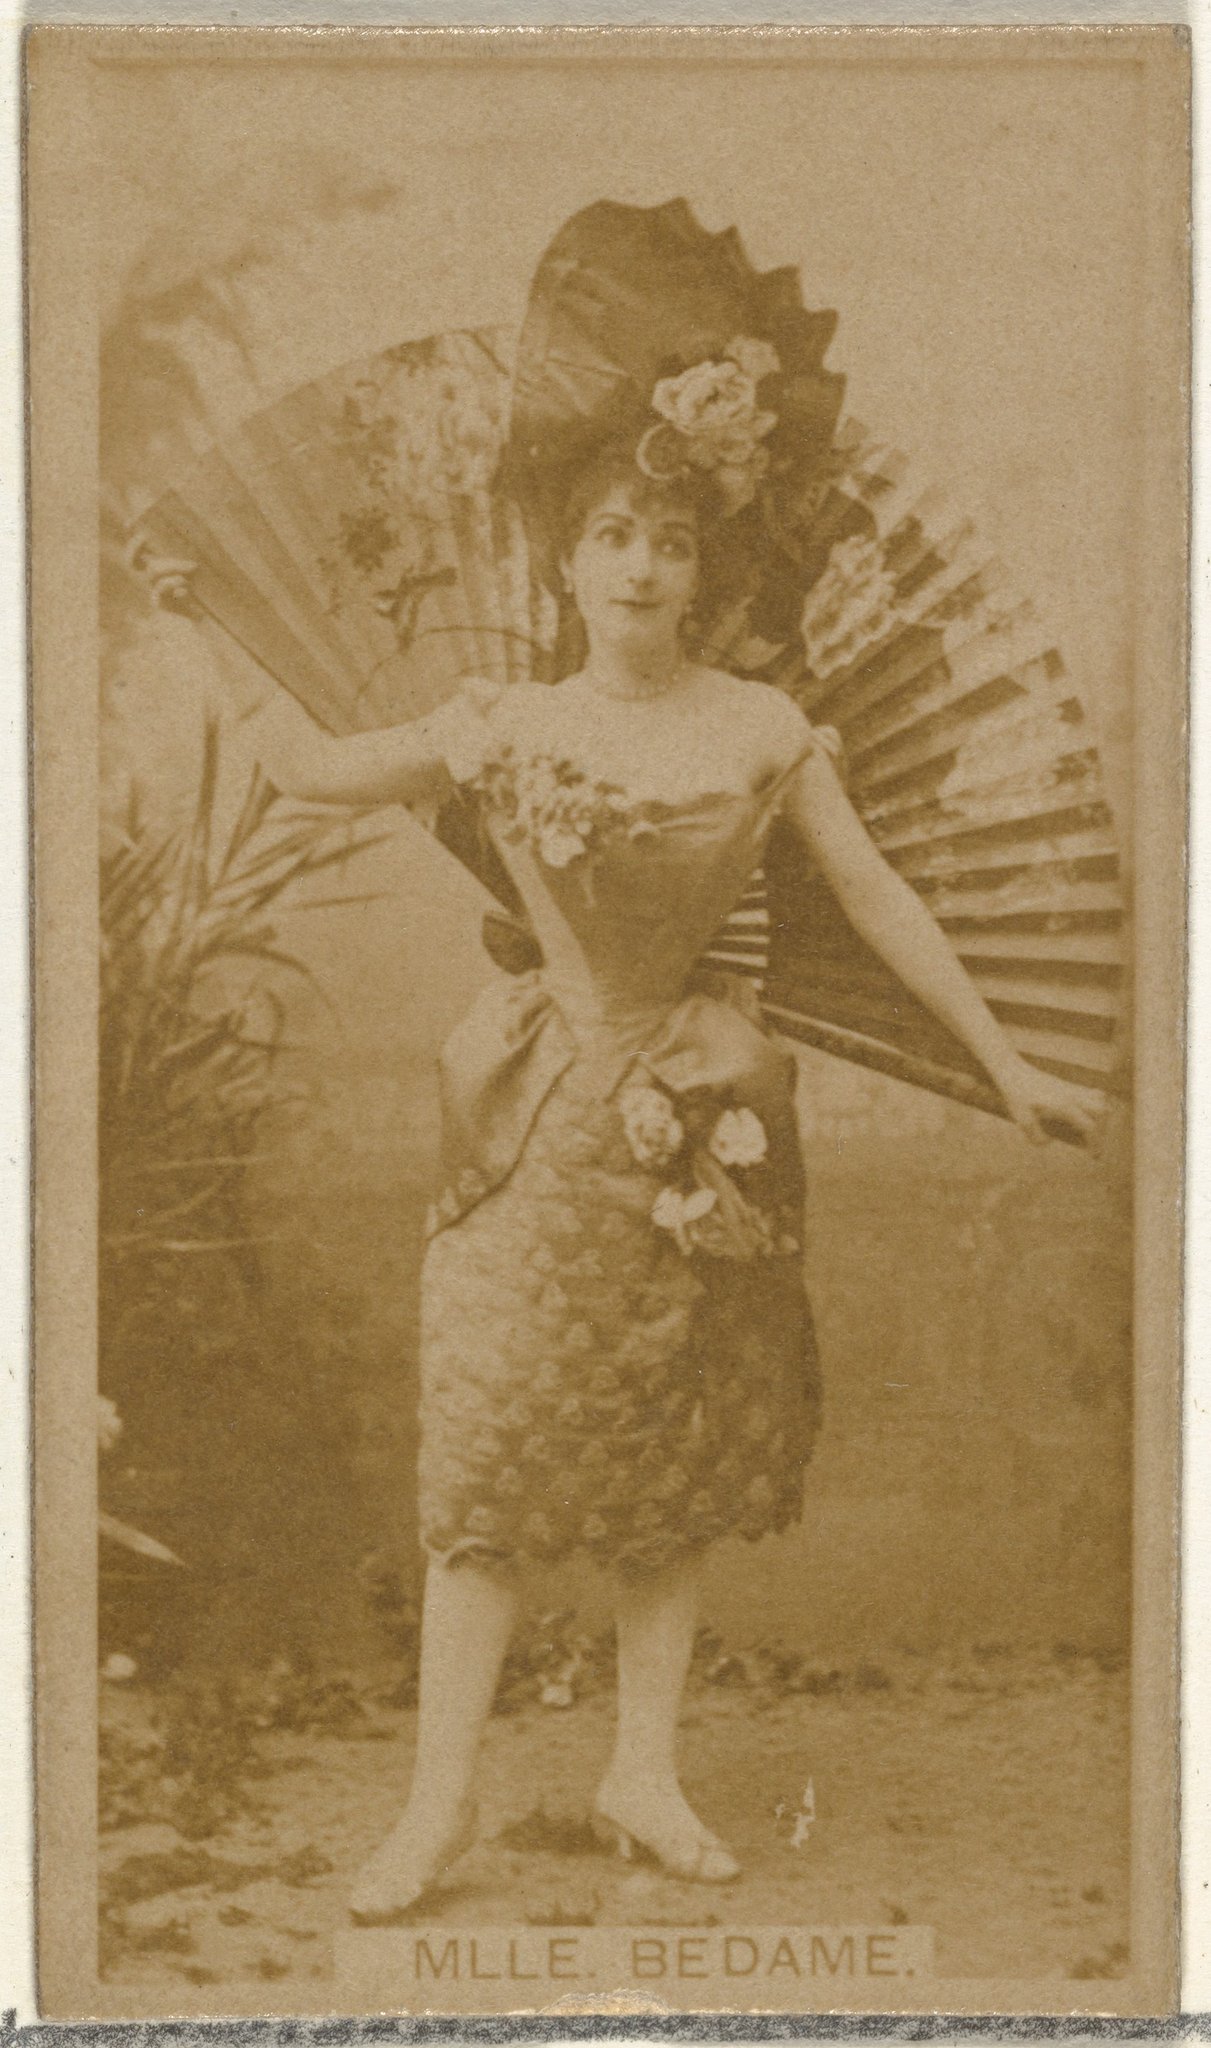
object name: photograph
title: Mlle. Bedame, from the Actors and Actresses series (N145-8) issued by Duke Sons & Co. to promote Duke Cigarettes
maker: w. duke, sons & co.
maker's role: publisher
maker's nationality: american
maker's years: 1870-1920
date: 1891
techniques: albumen silver print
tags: portraits,women,actresses